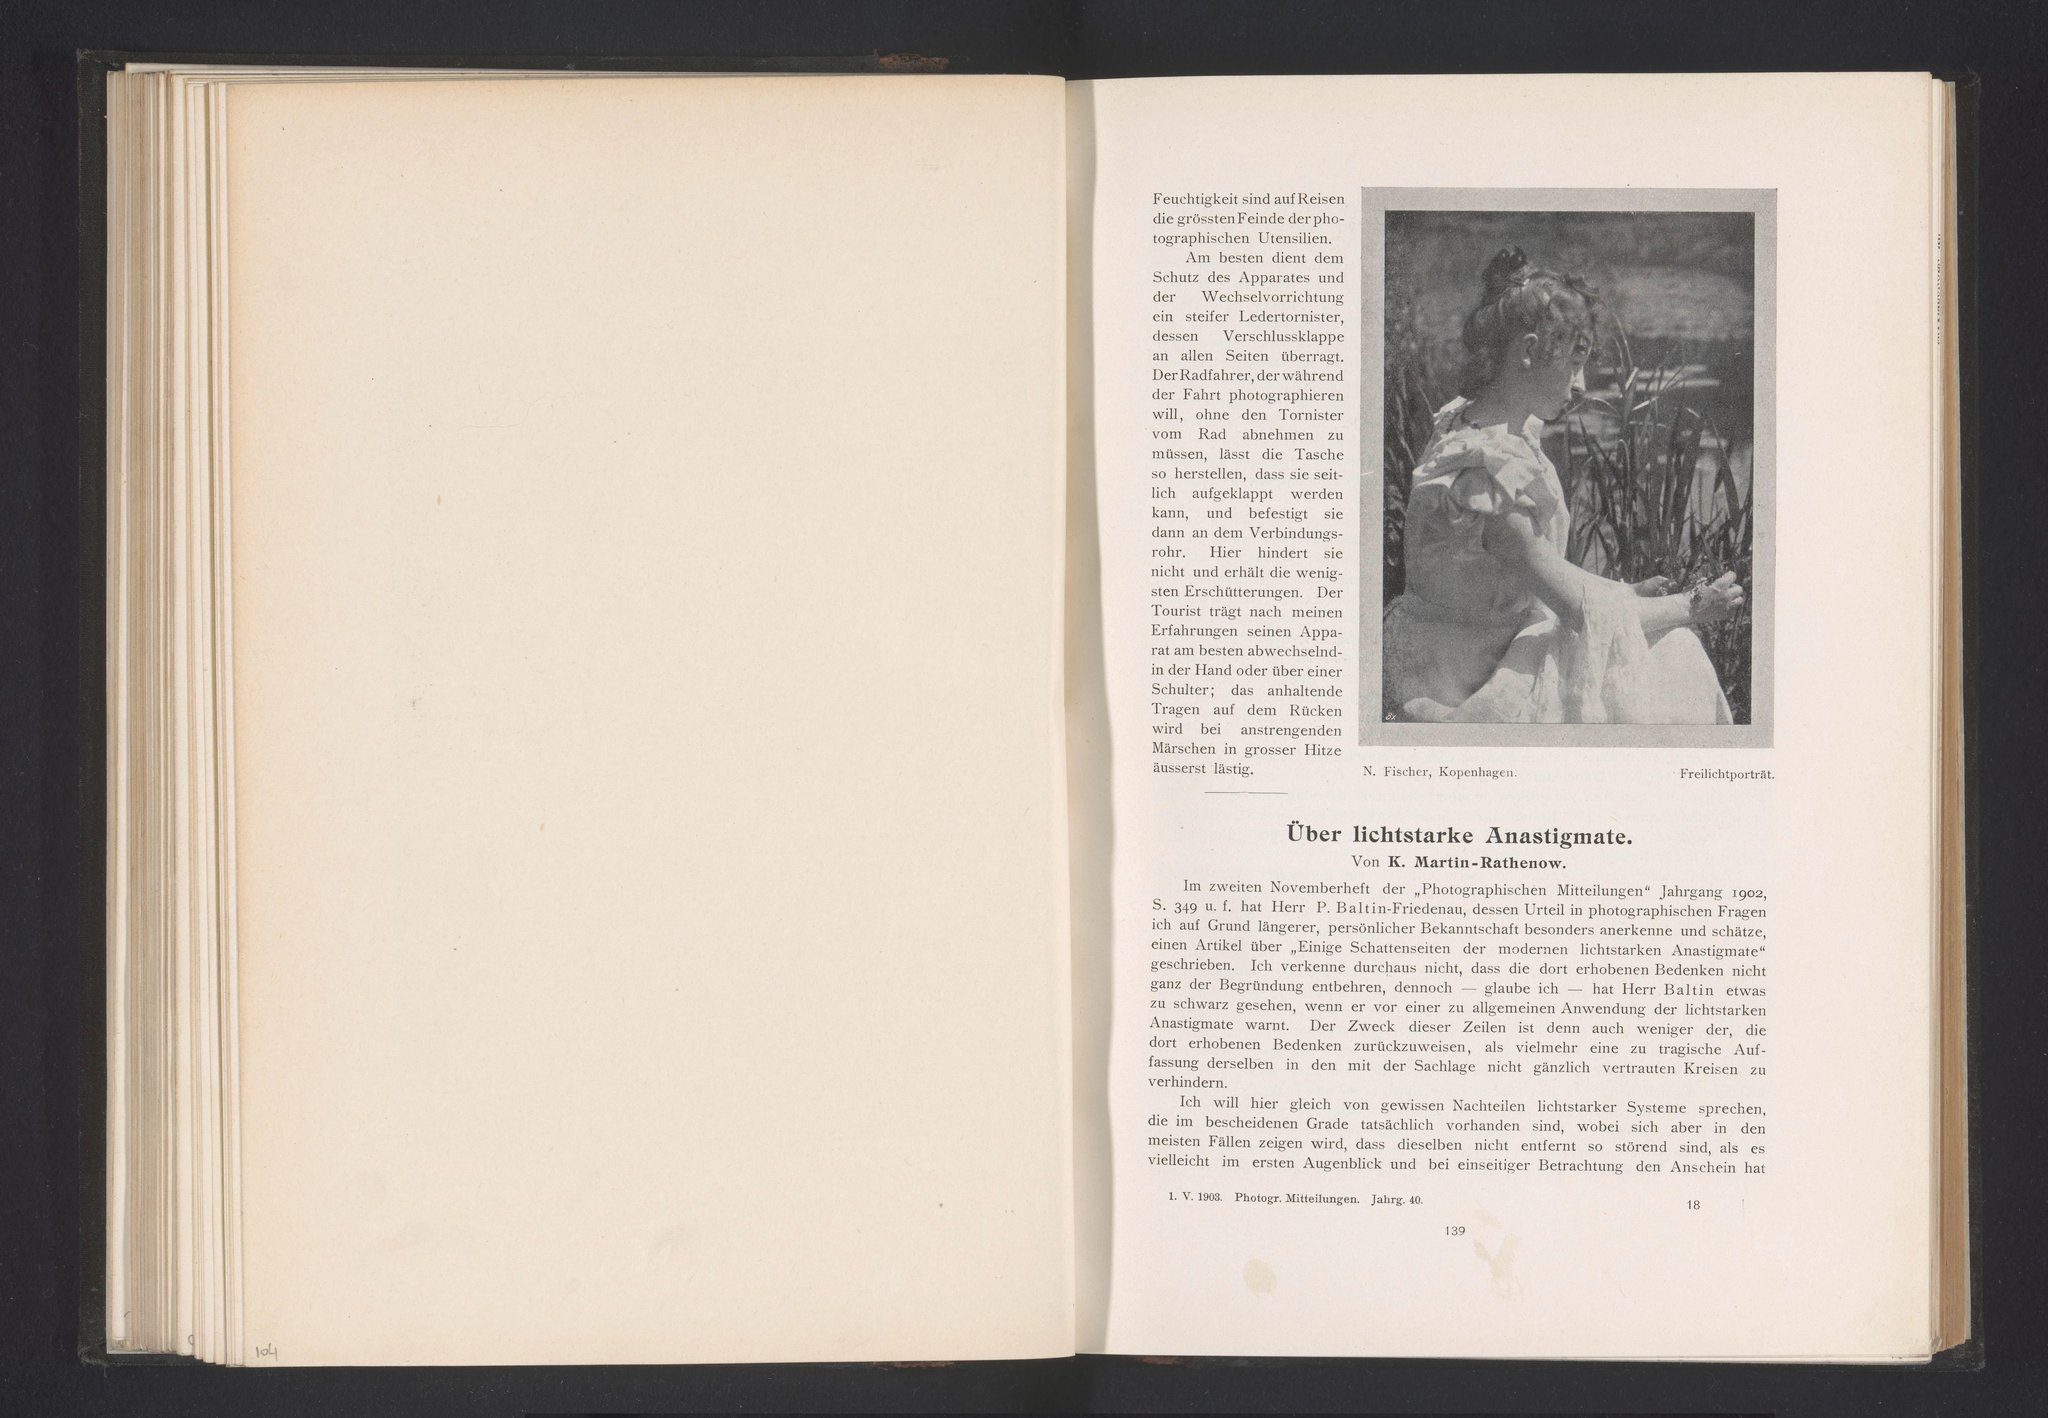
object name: page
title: Freilichtporträt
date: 1898-1903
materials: paper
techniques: autotype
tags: historical persons - bb - woman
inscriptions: inscription: ‘Kopenhagen’, monogram: ‘BX’